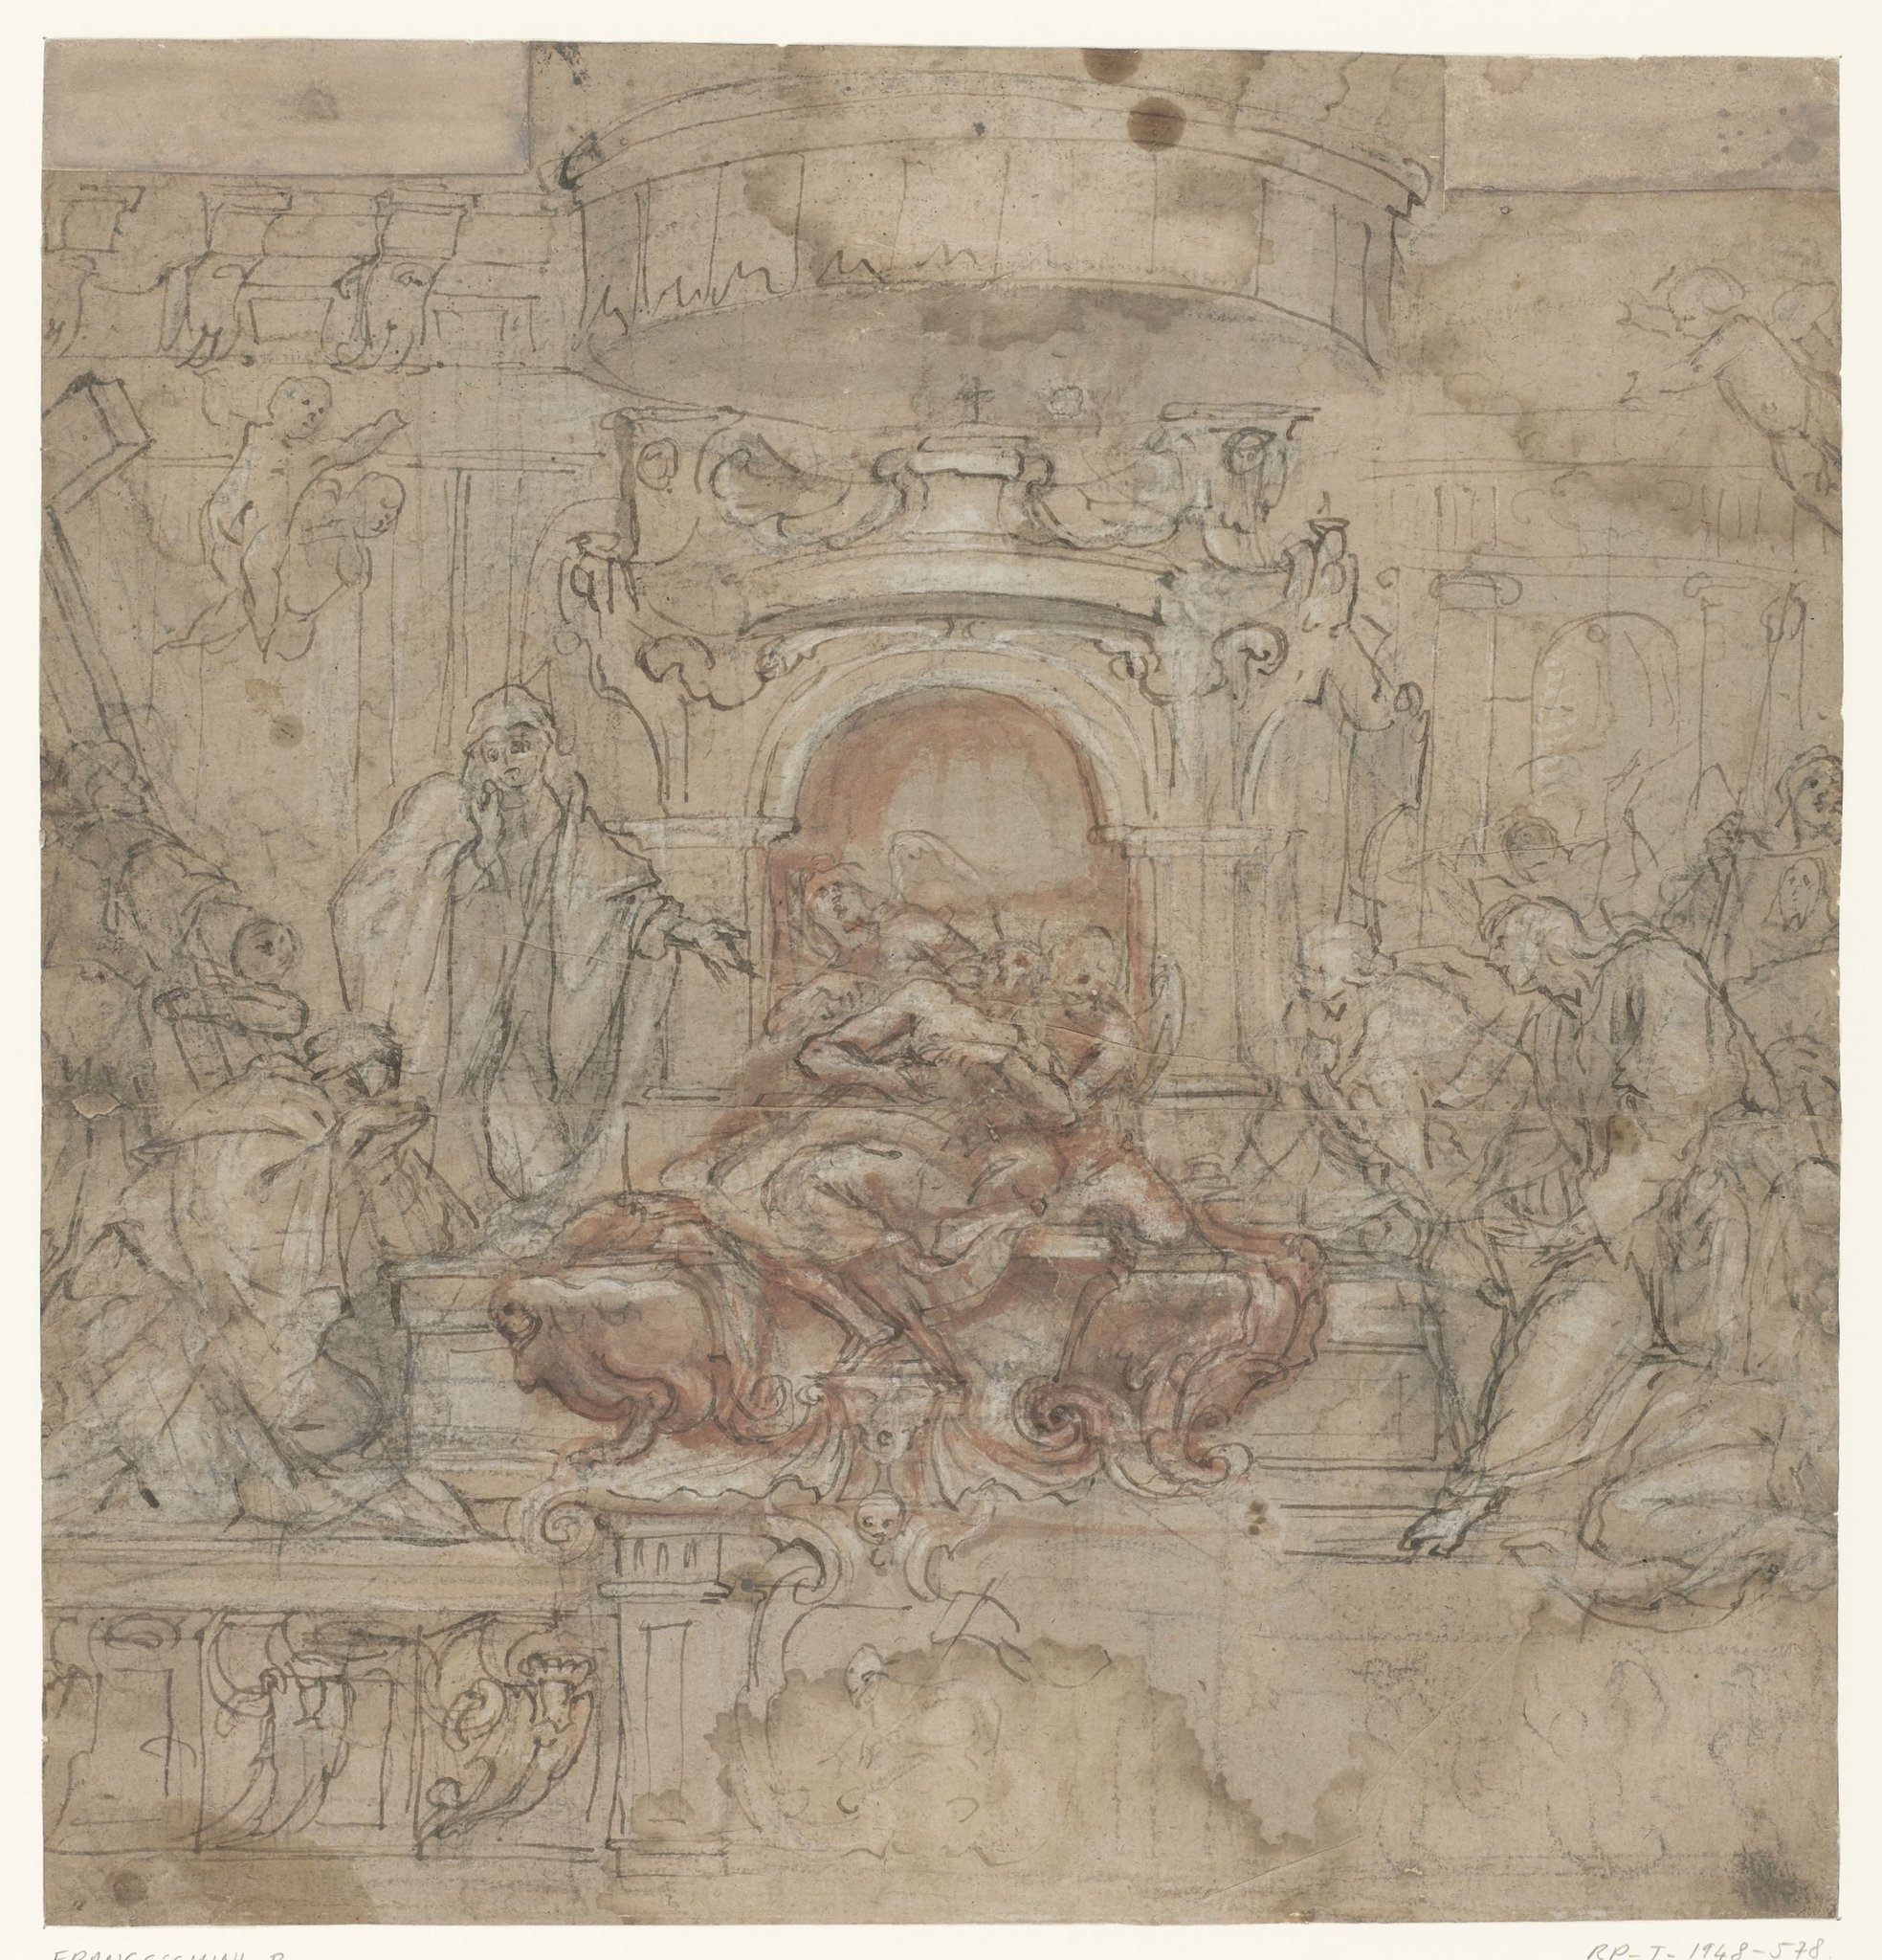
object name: drawing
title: Ontwerp voor een scenografisch Paasaltaar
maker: baldassare franceschini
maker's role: draughtsman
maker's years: 1611-1689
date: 1645-1649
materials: chalk, ink, paint, paper, watercolor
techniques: brush, pen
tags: christ lamented by angels